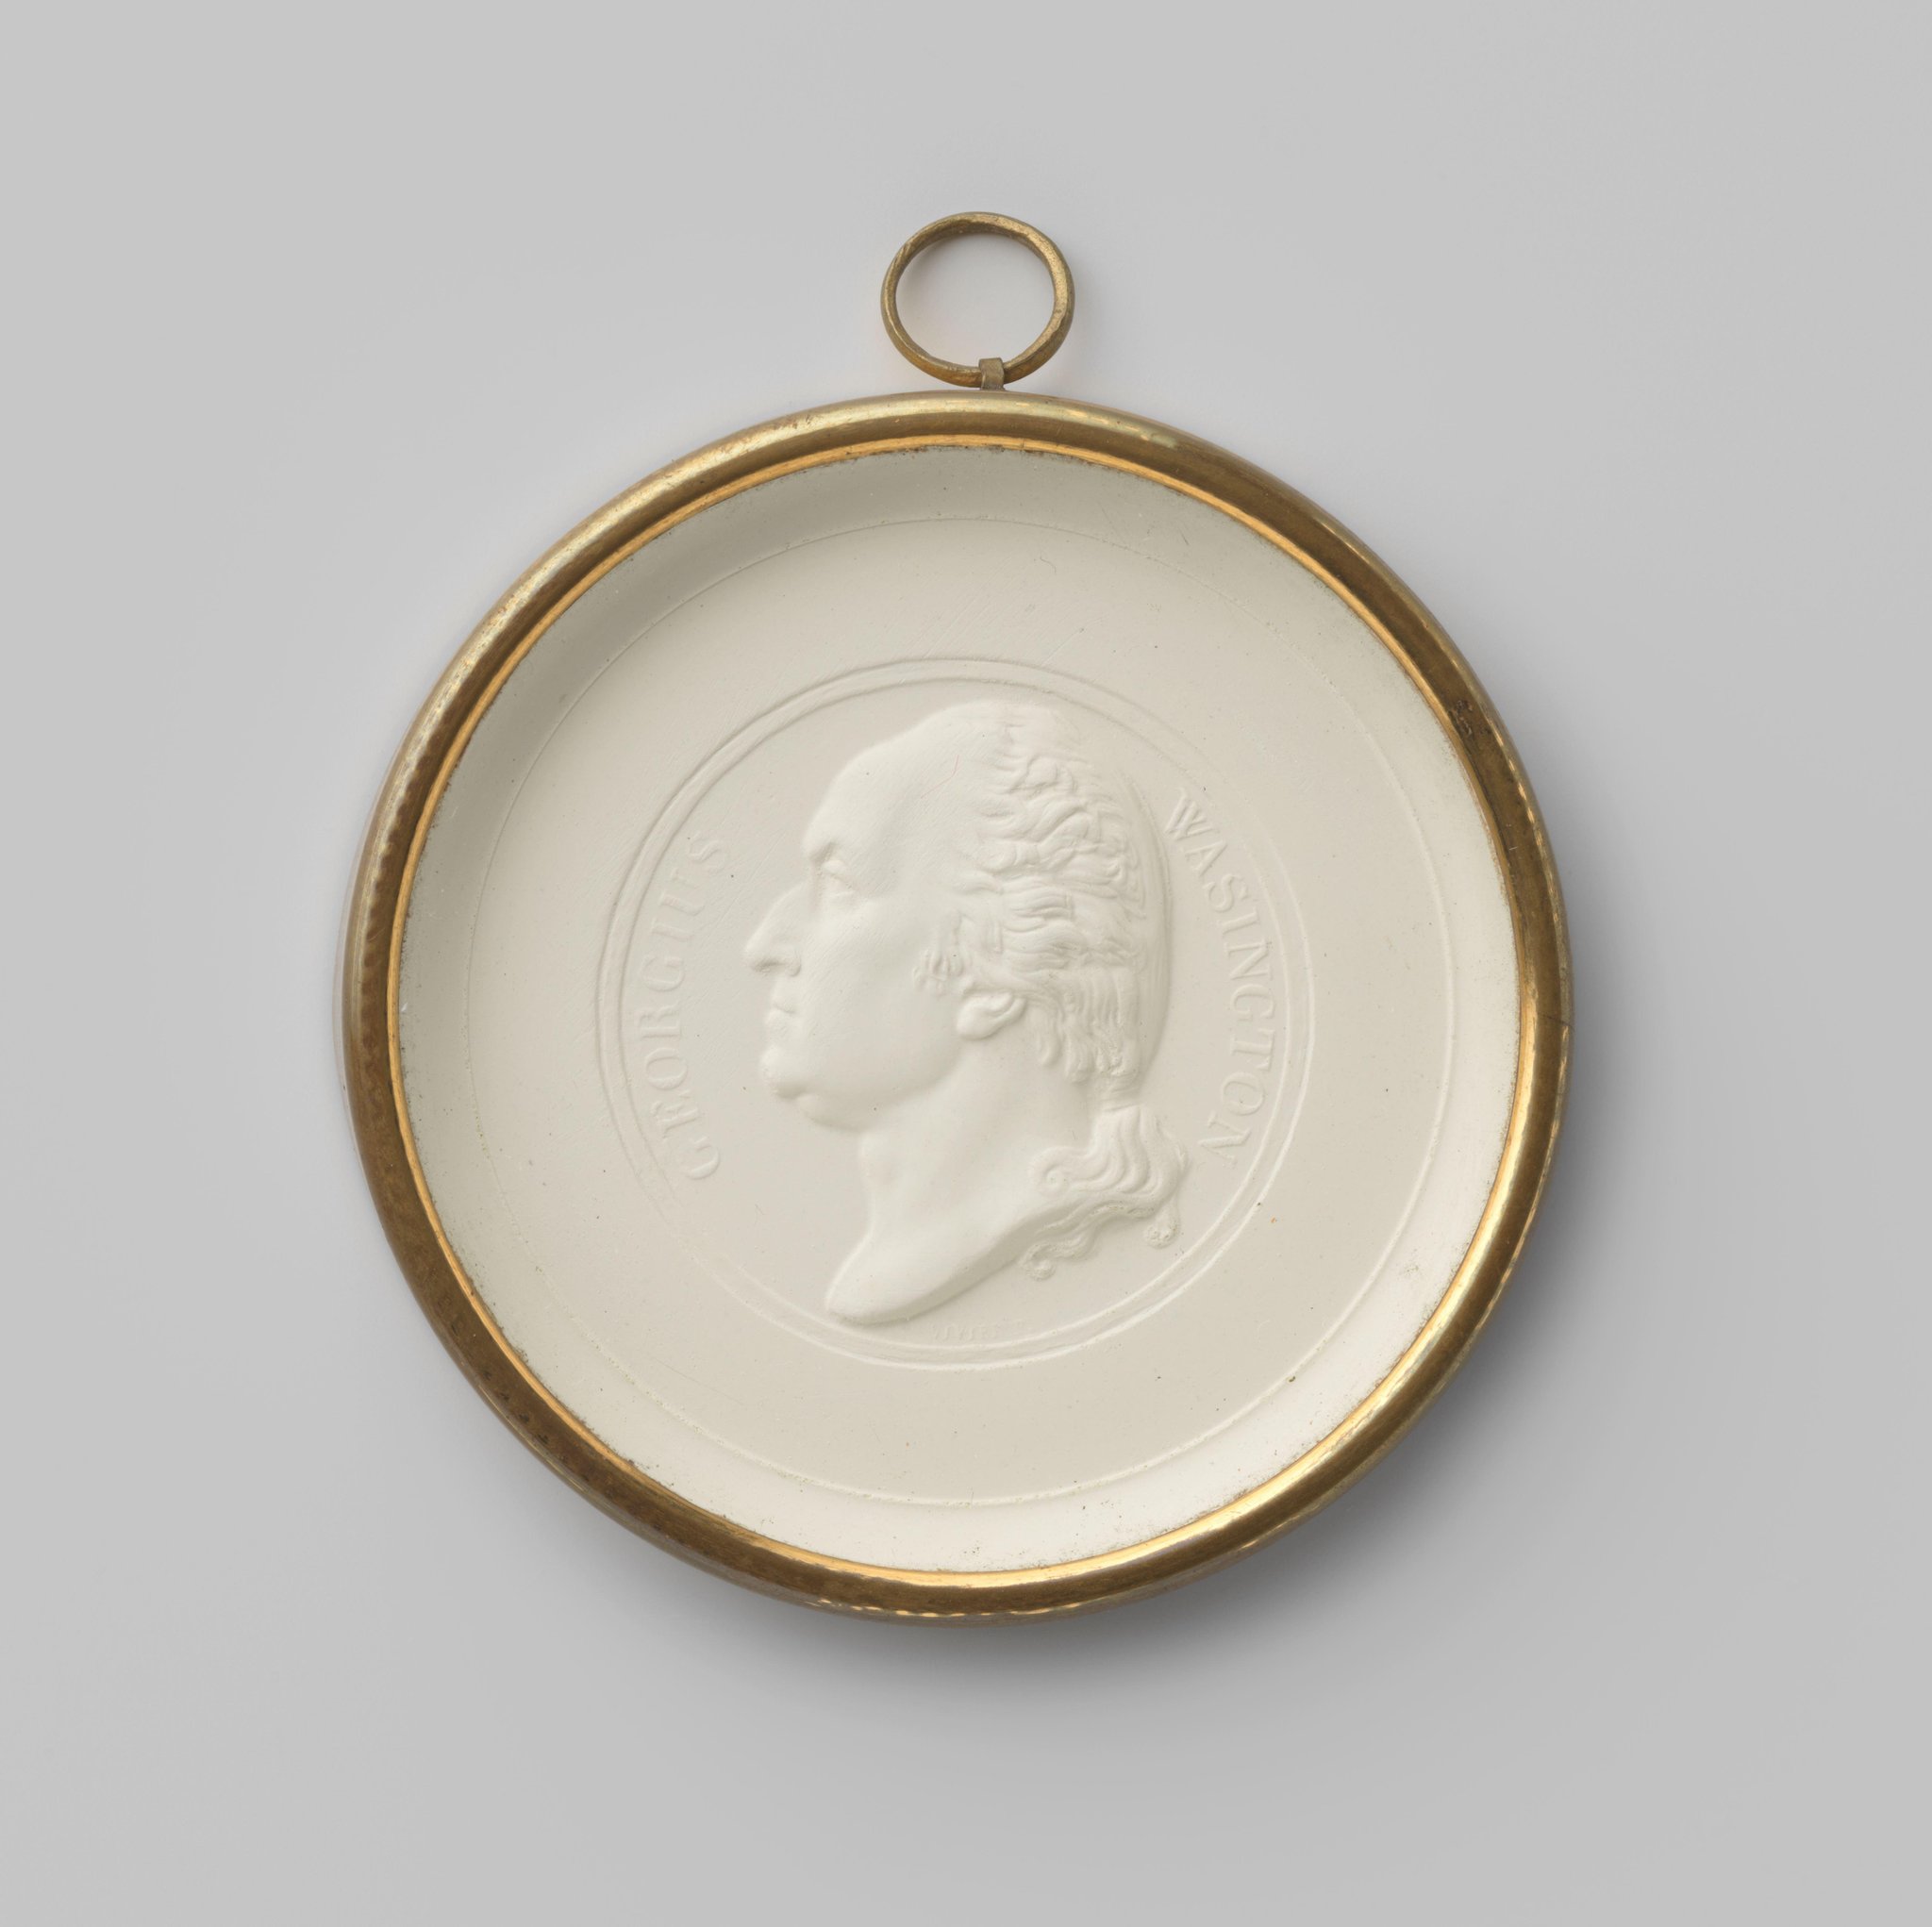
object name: locket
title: George Washington, president der Verenigde Staten van Amerika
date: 1840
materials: brass, glass, gypsum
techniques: casting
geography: berlin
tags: virginia, mount vernon, president, george washington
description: Eenzijdig medaillon in messing ring achter glas aan draagoog en draagring. Voorzijde: borststuk man naar links binnen omschrift. Keerzijde: etiket met opschrift.